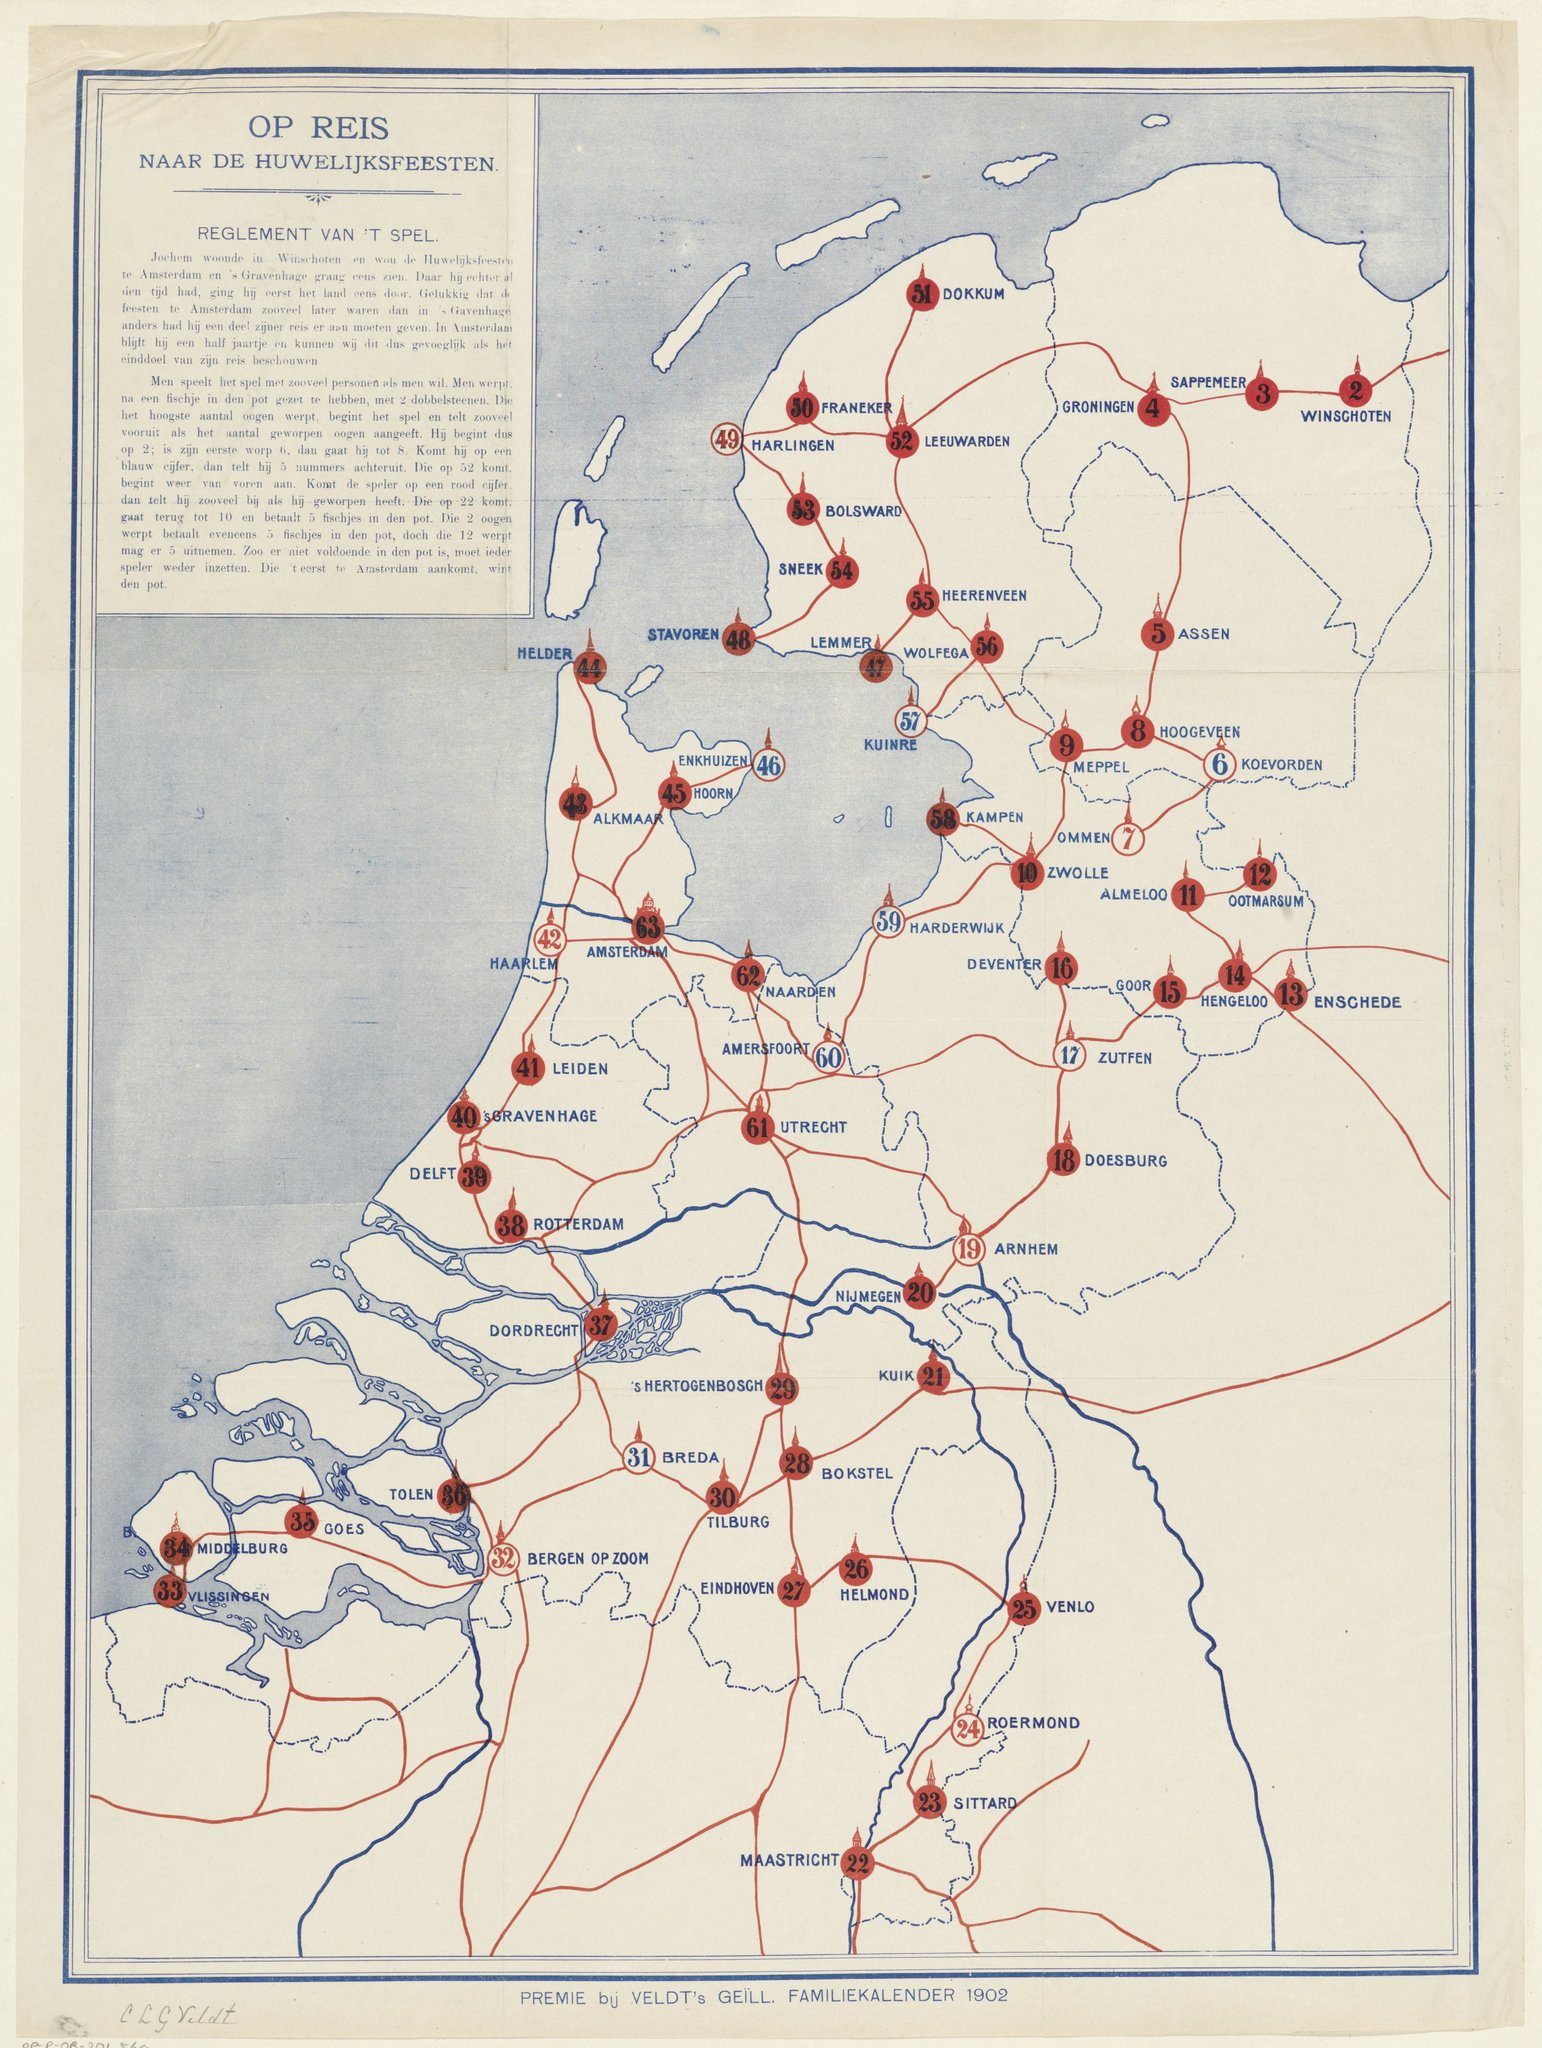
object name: print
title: Op reis / naar de huwelijksfeesten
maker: c.l.g. veldt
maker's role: publisher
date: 1902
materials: paper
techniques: lithograph, letterpress printing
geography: netherlands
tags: board-games of chance, board-games, netherlands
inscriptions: collector's mark: Lugt 2760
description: Bordspel met de kaart van Nederland met 63 genummerde met rondjes en plaatsnamen. Titel en spelregels linksboven in boekdruk.